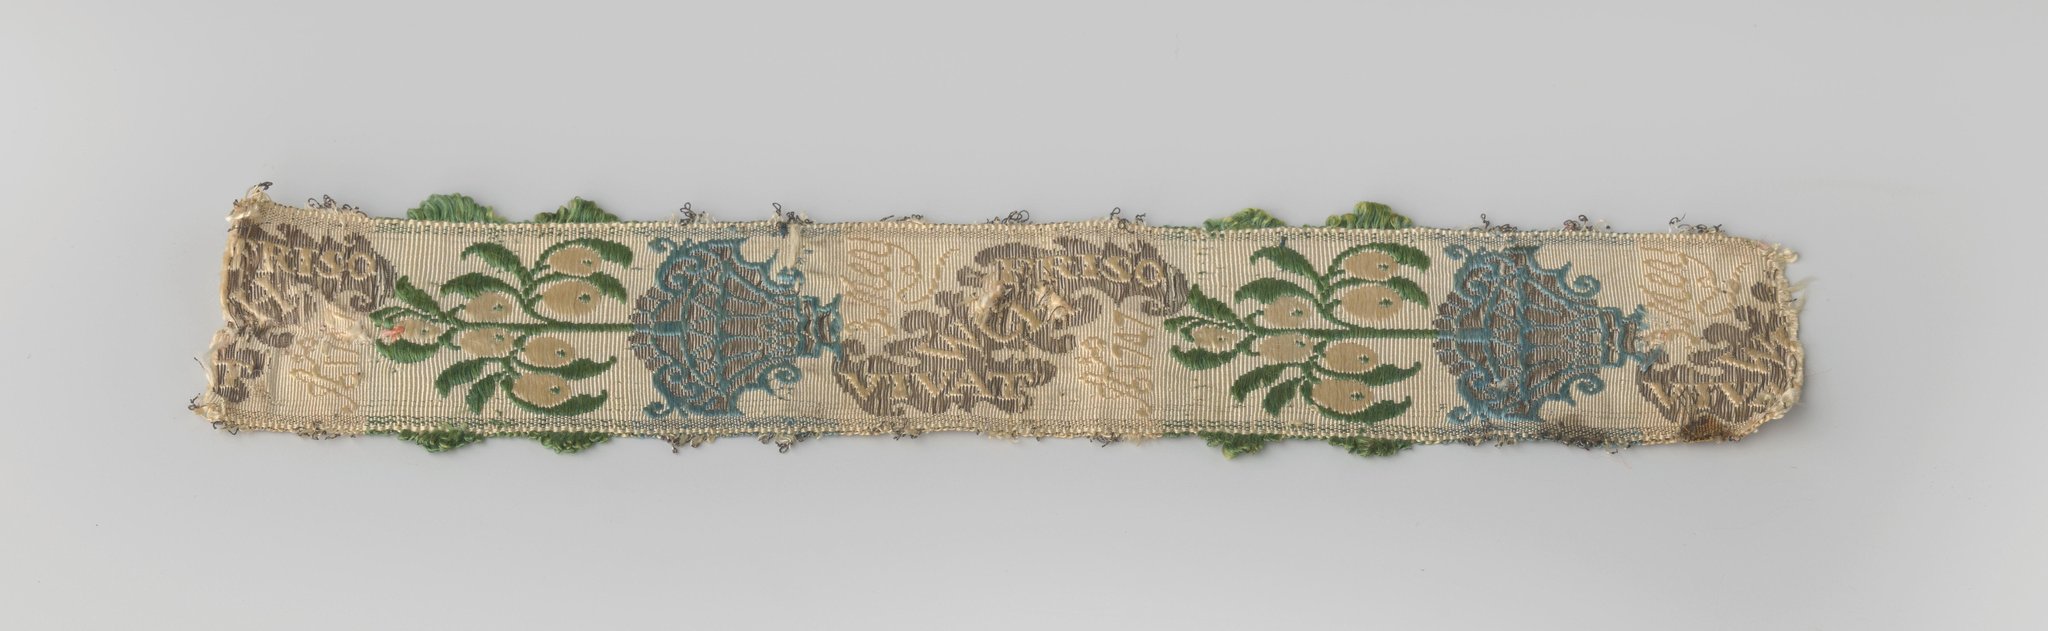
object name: ribbon material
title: Oranjelint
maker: Anonymous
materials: silk, thread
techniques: weave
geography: netherlands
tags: willem iv (prins van oranje-nassau)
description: Zijden lint met aan de lange zijden franjes van zilverdraad en franjes van groene zijde. Afwisselend patroon bestaande uit een groene boom met 7 grote oranjeappels in sierlijke zilver met blauwe vaas op grijsachtige fond, en opschrift in geel op grillige zilveren band met aan weerskanten de datum op witachtige fond. Aan de twee uiteinden dwars door het opschrift afgesneden. Opschrift: VIVAT / WCH / FRISO. tussenin: Ao 1747 / 3 mey (1 x herhaald).